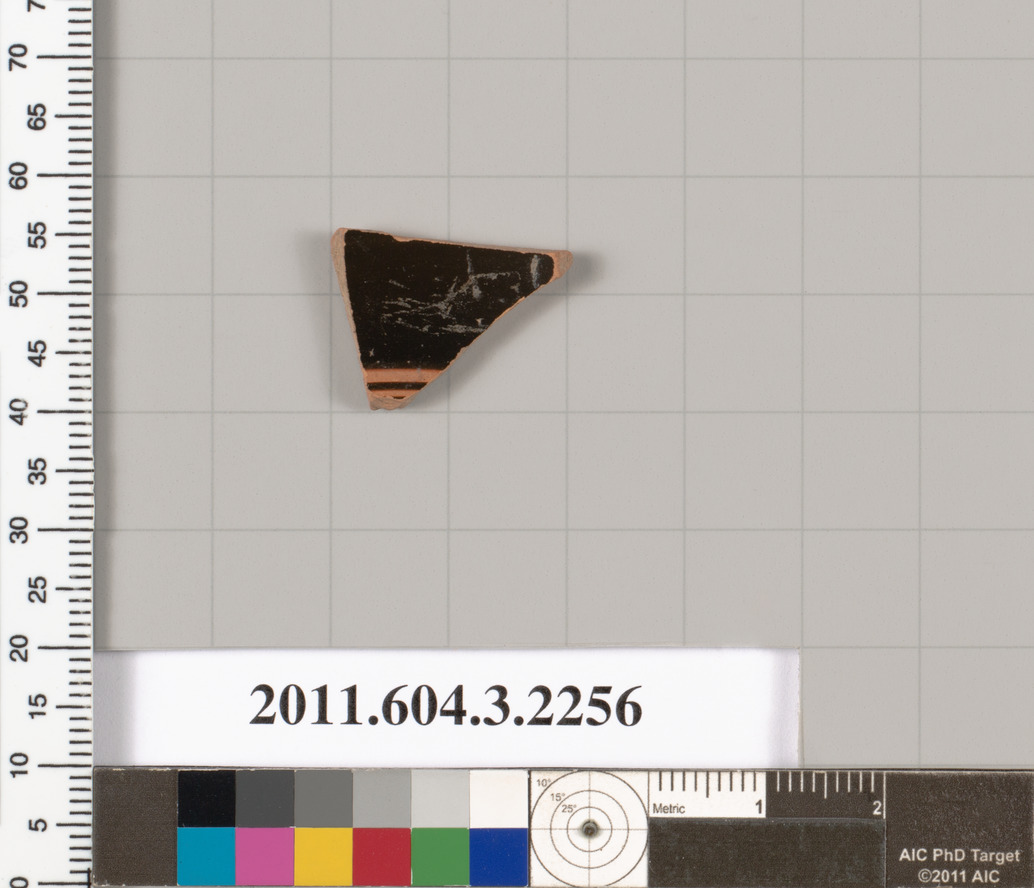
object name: kylix fragment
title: Terracotta fragment of a kylix (drinking cup)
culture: greek, attic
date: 600-401 BCE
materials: terracotta